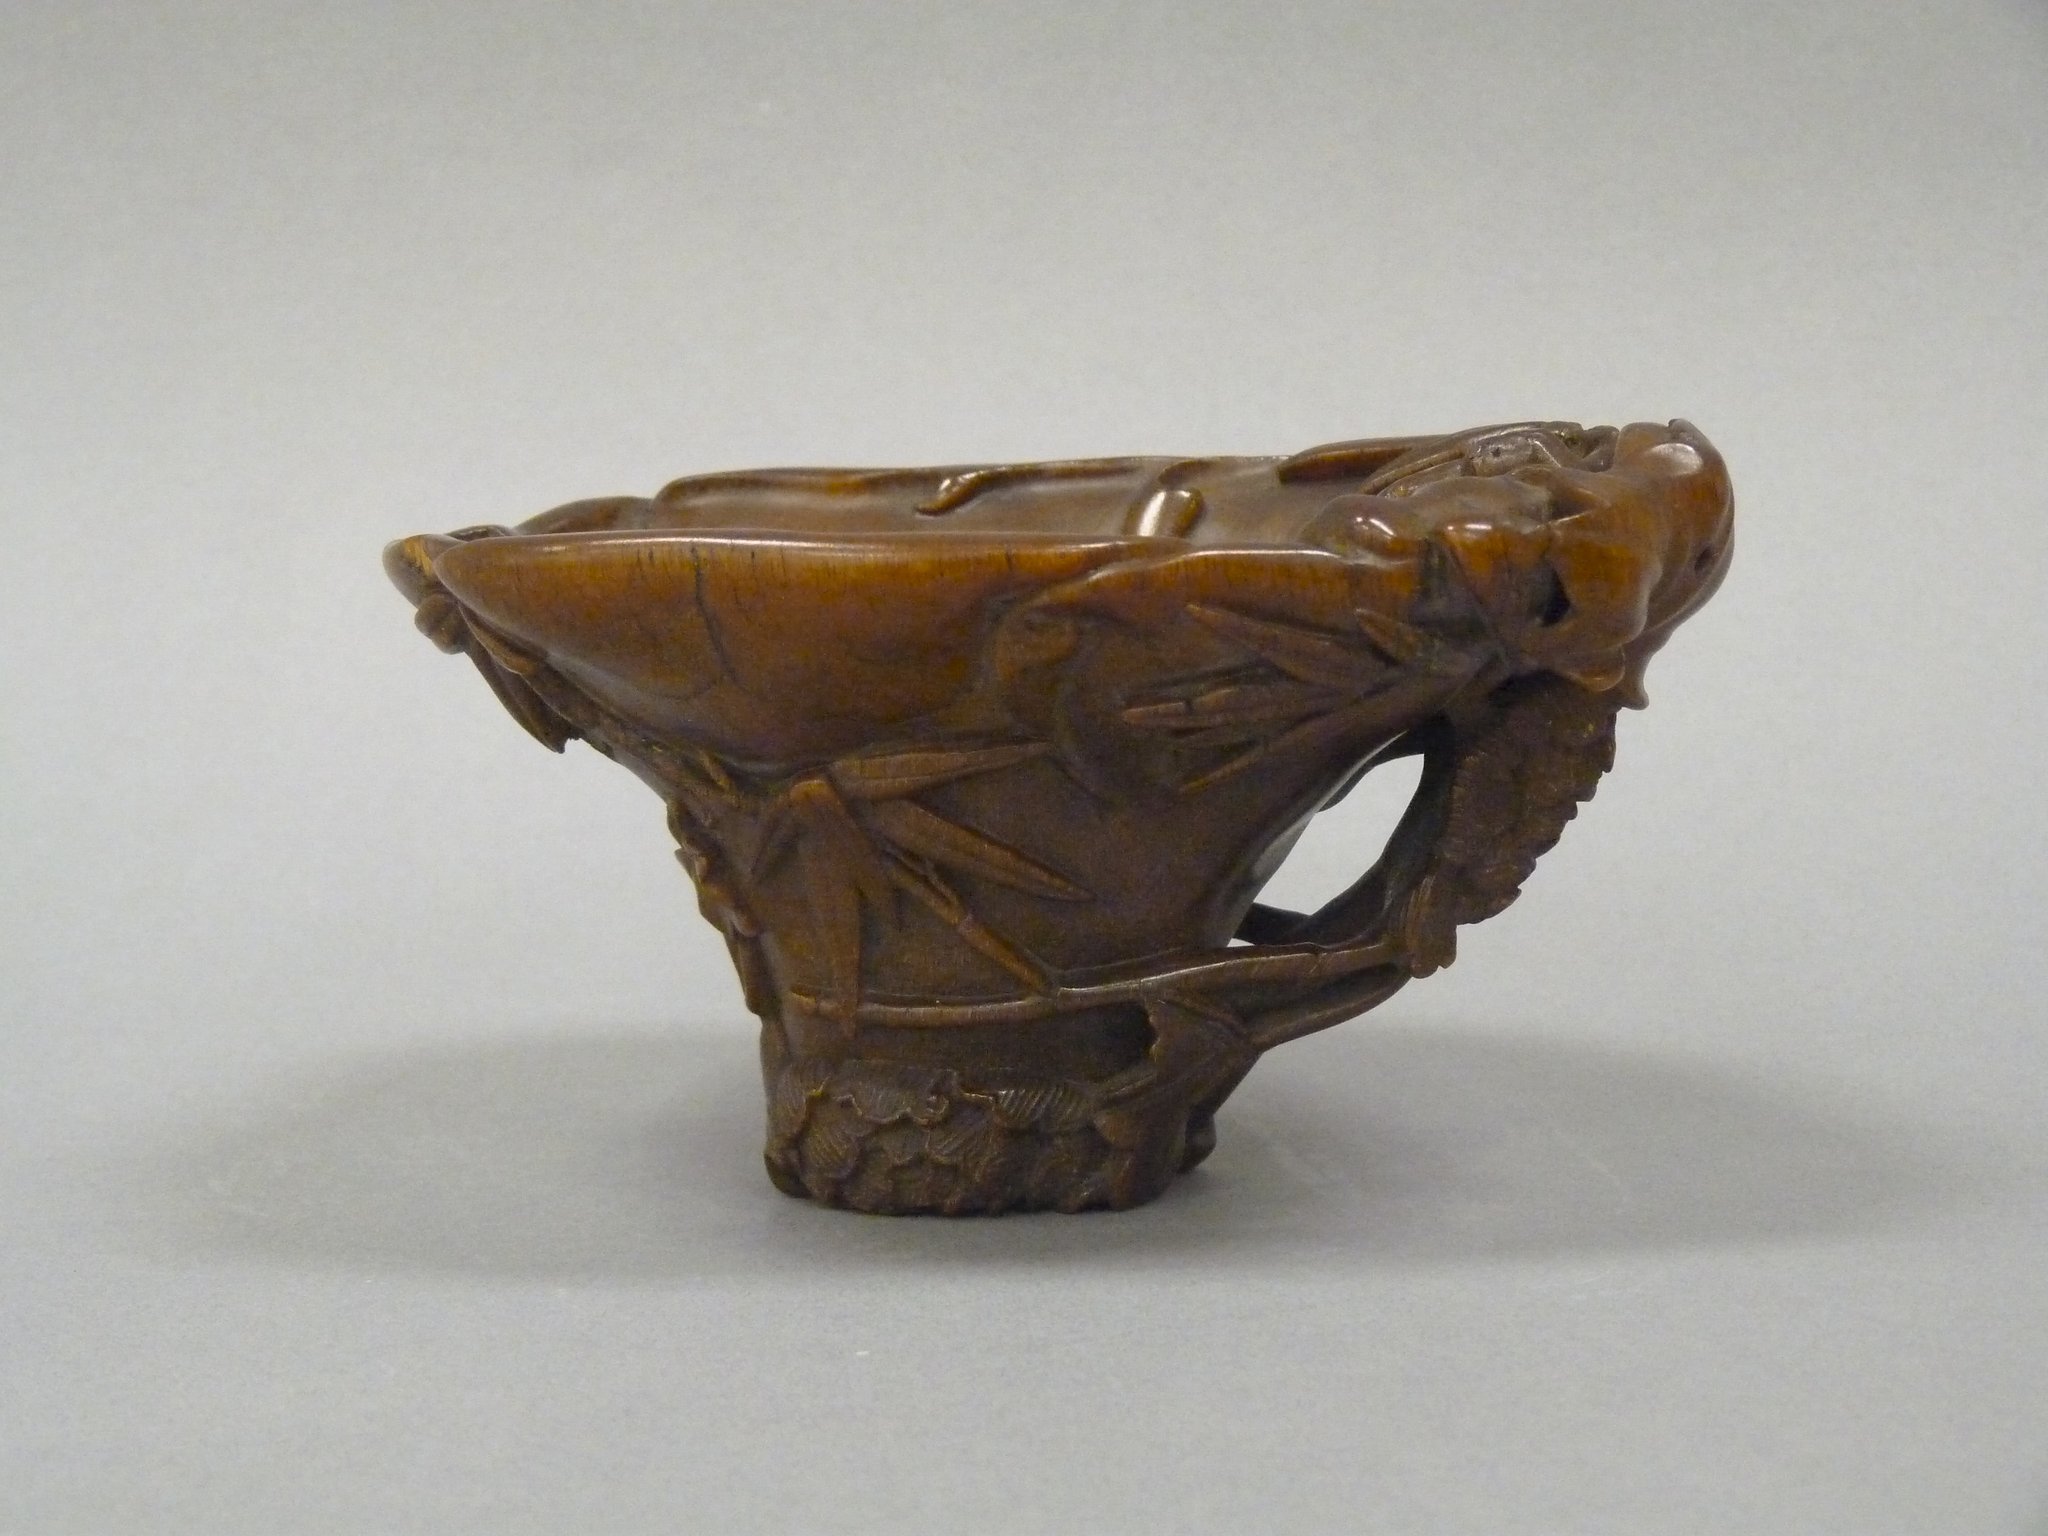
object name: cup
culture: chinese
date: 1600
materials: horn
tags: leaves